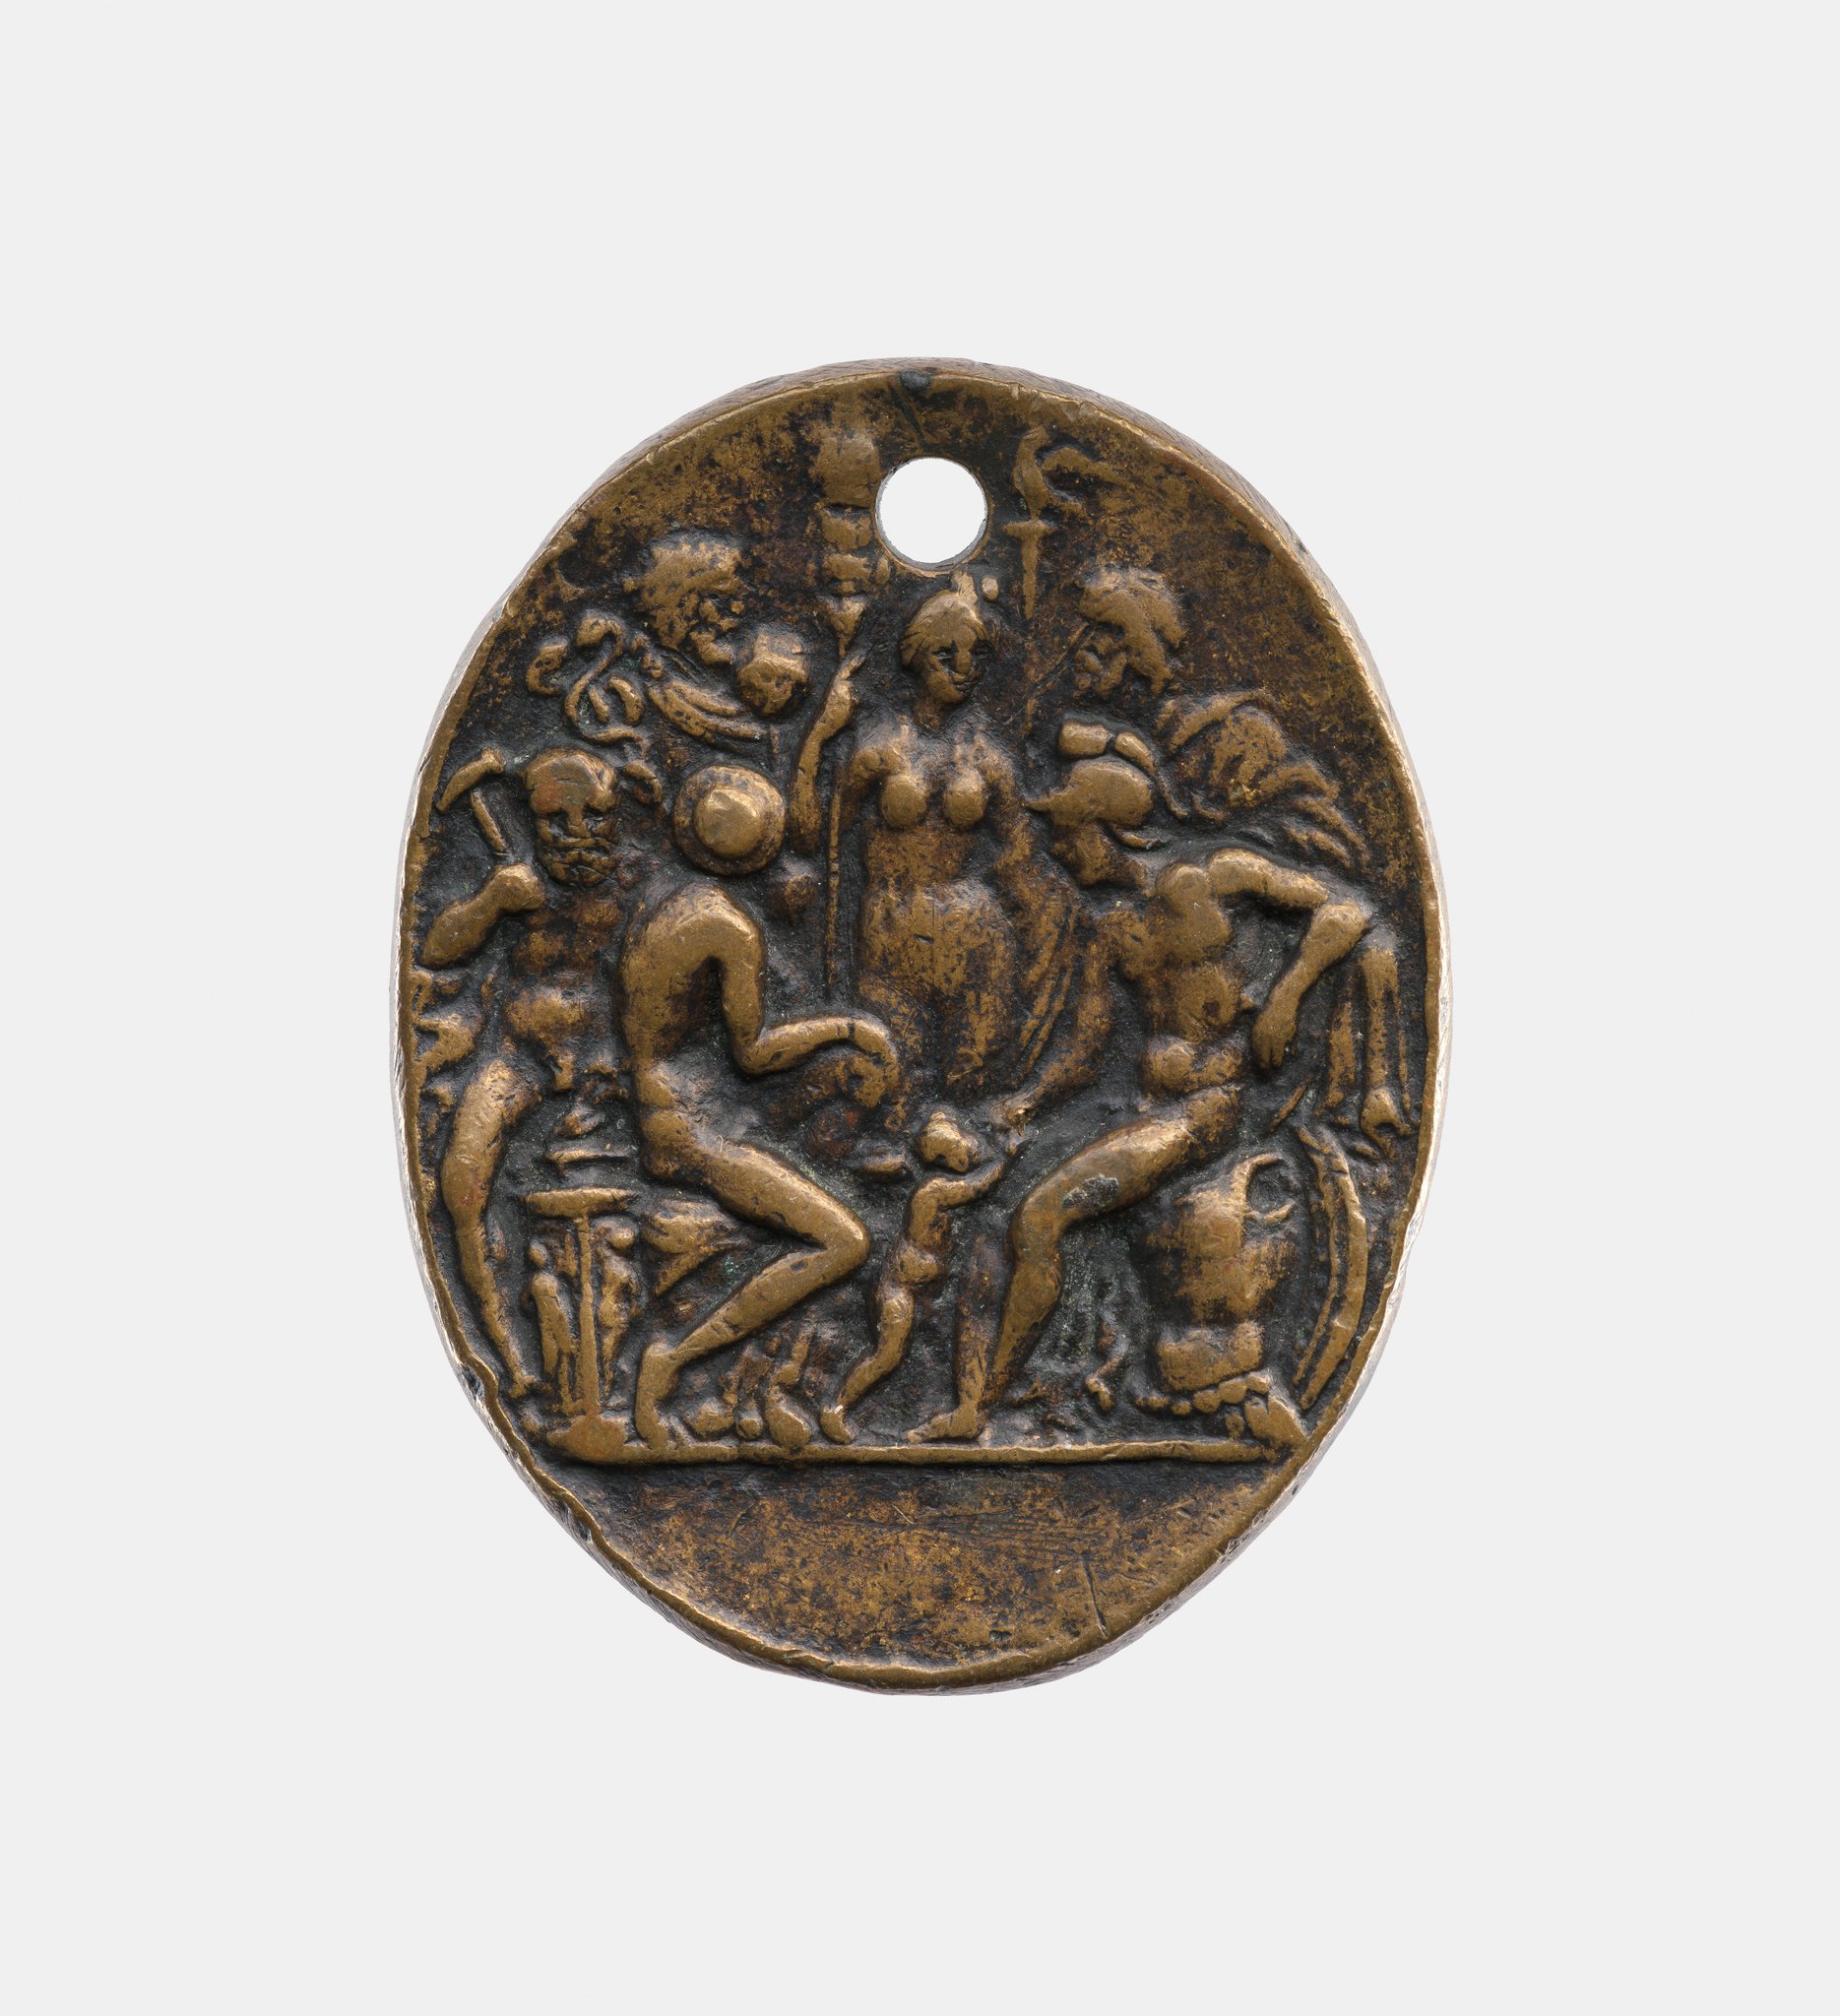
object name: medal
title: Assembly of gods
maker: master io. f.f.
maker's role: artist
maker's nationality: italian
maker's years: 1400-1550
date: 1434-1466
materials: bronze